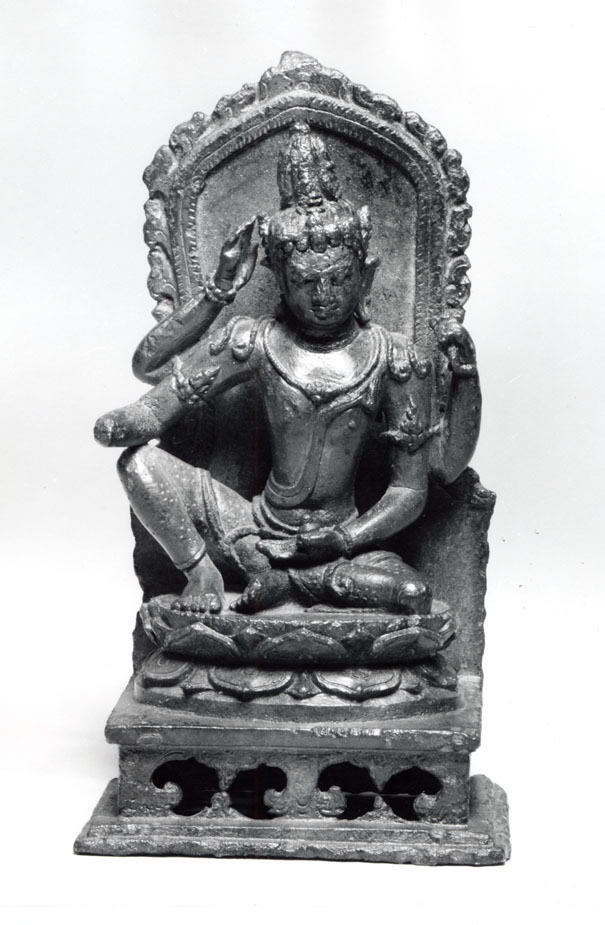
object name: figurine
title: Seated Four-Armed Bodhisattva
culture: indonesian, javanese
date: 901-1000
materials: bronze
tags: buddhism,bodhisattvas